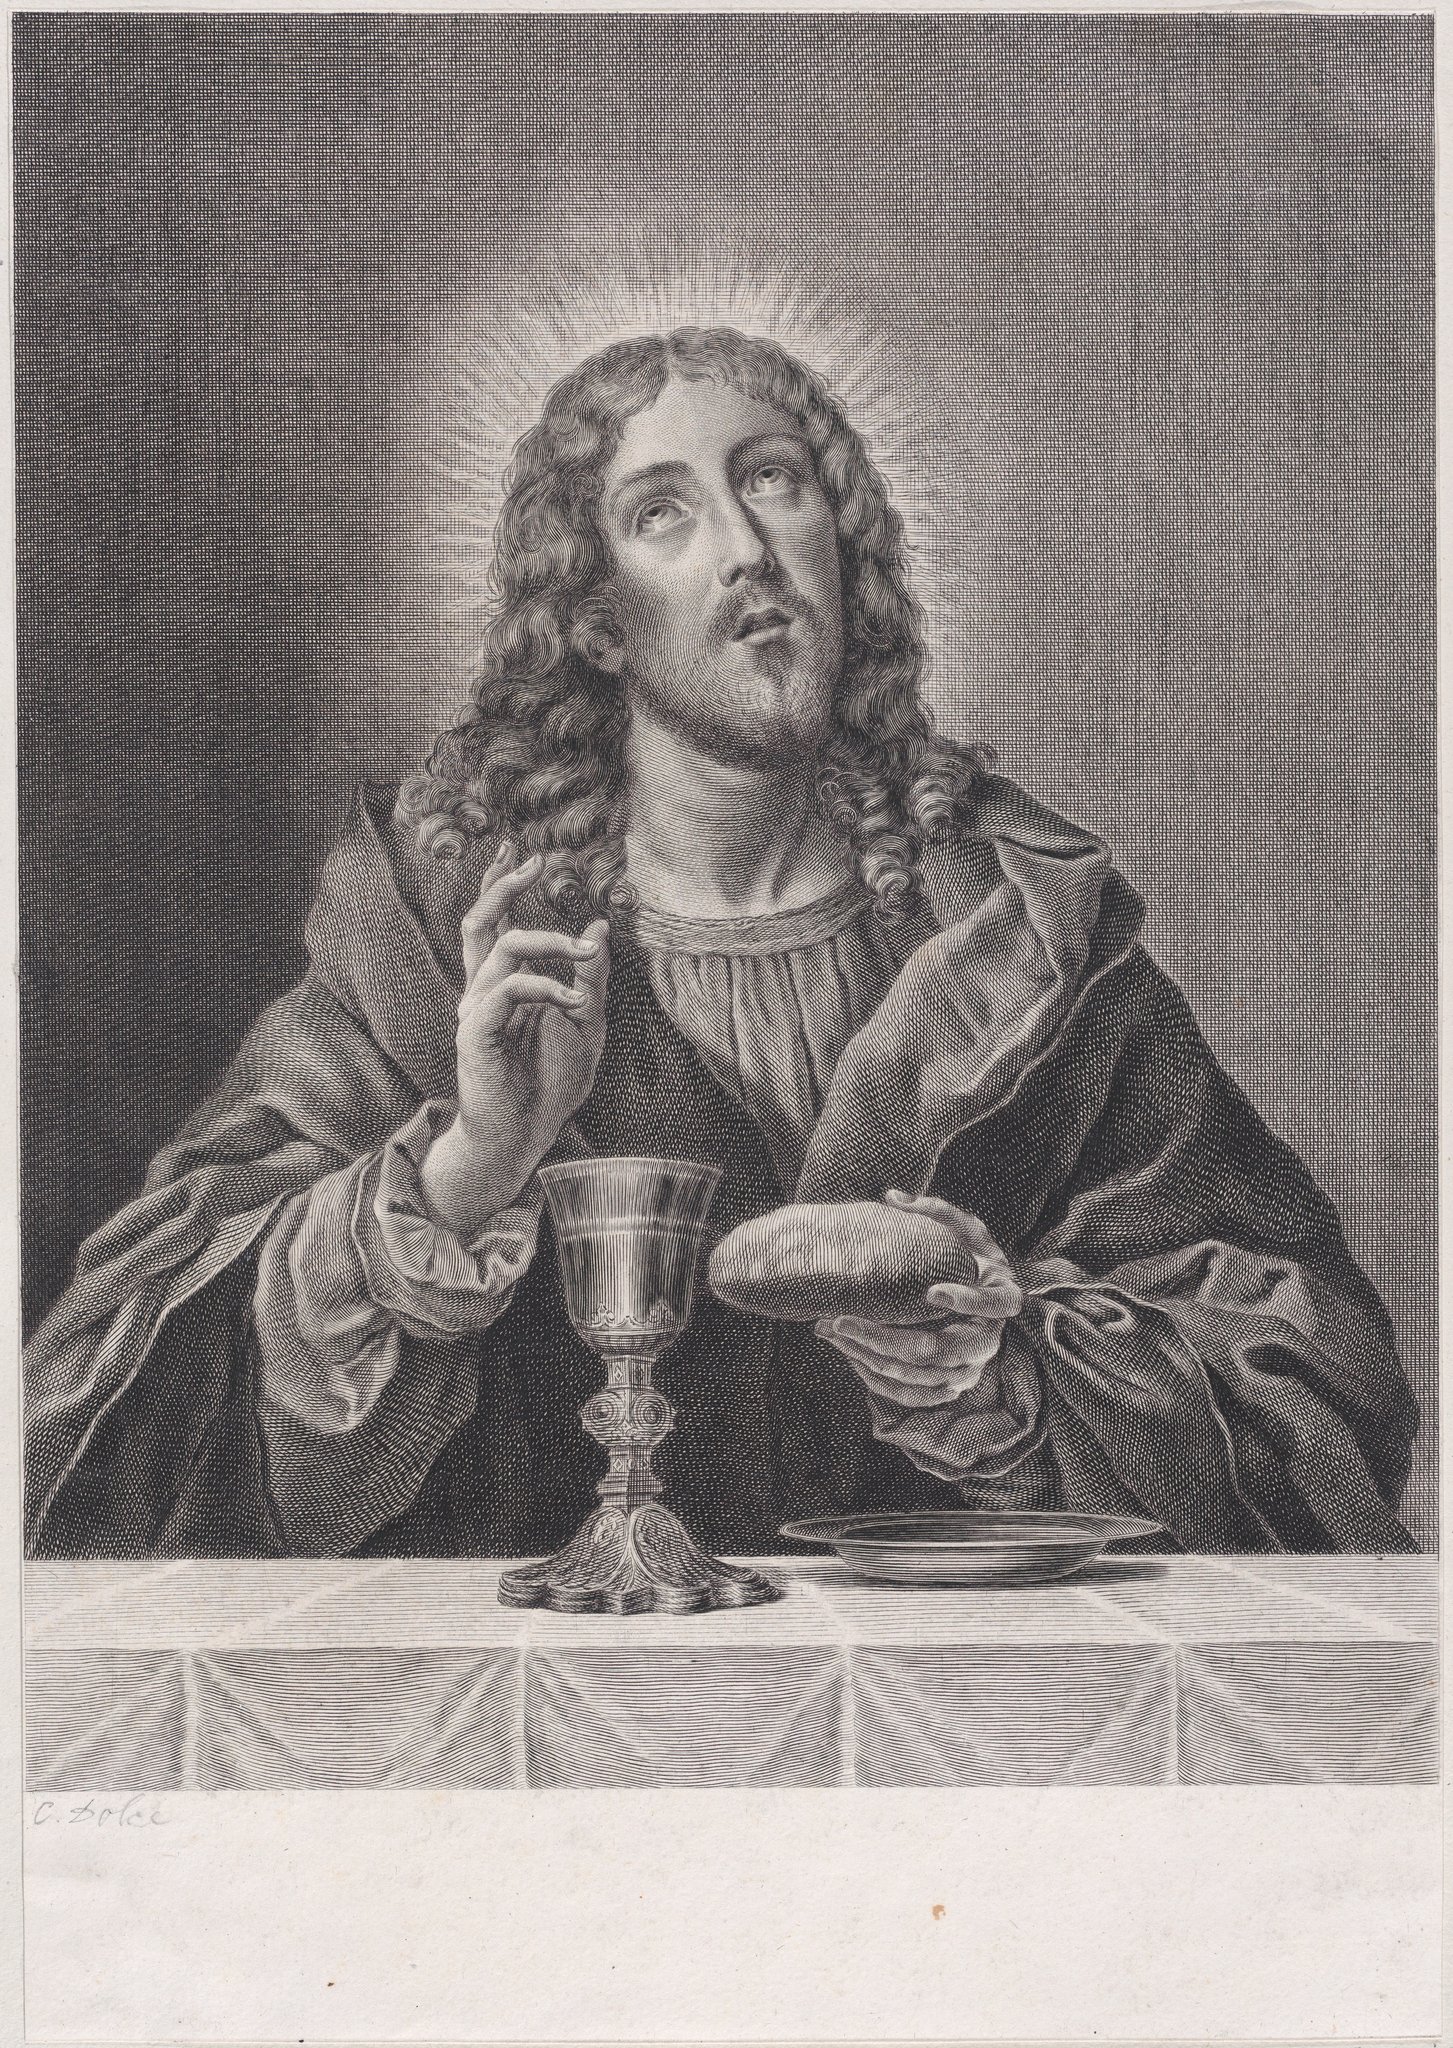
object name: print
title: Christ with symbols of the Eucharist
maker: Anonymous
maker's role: artist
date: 1650-1750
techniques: engraving